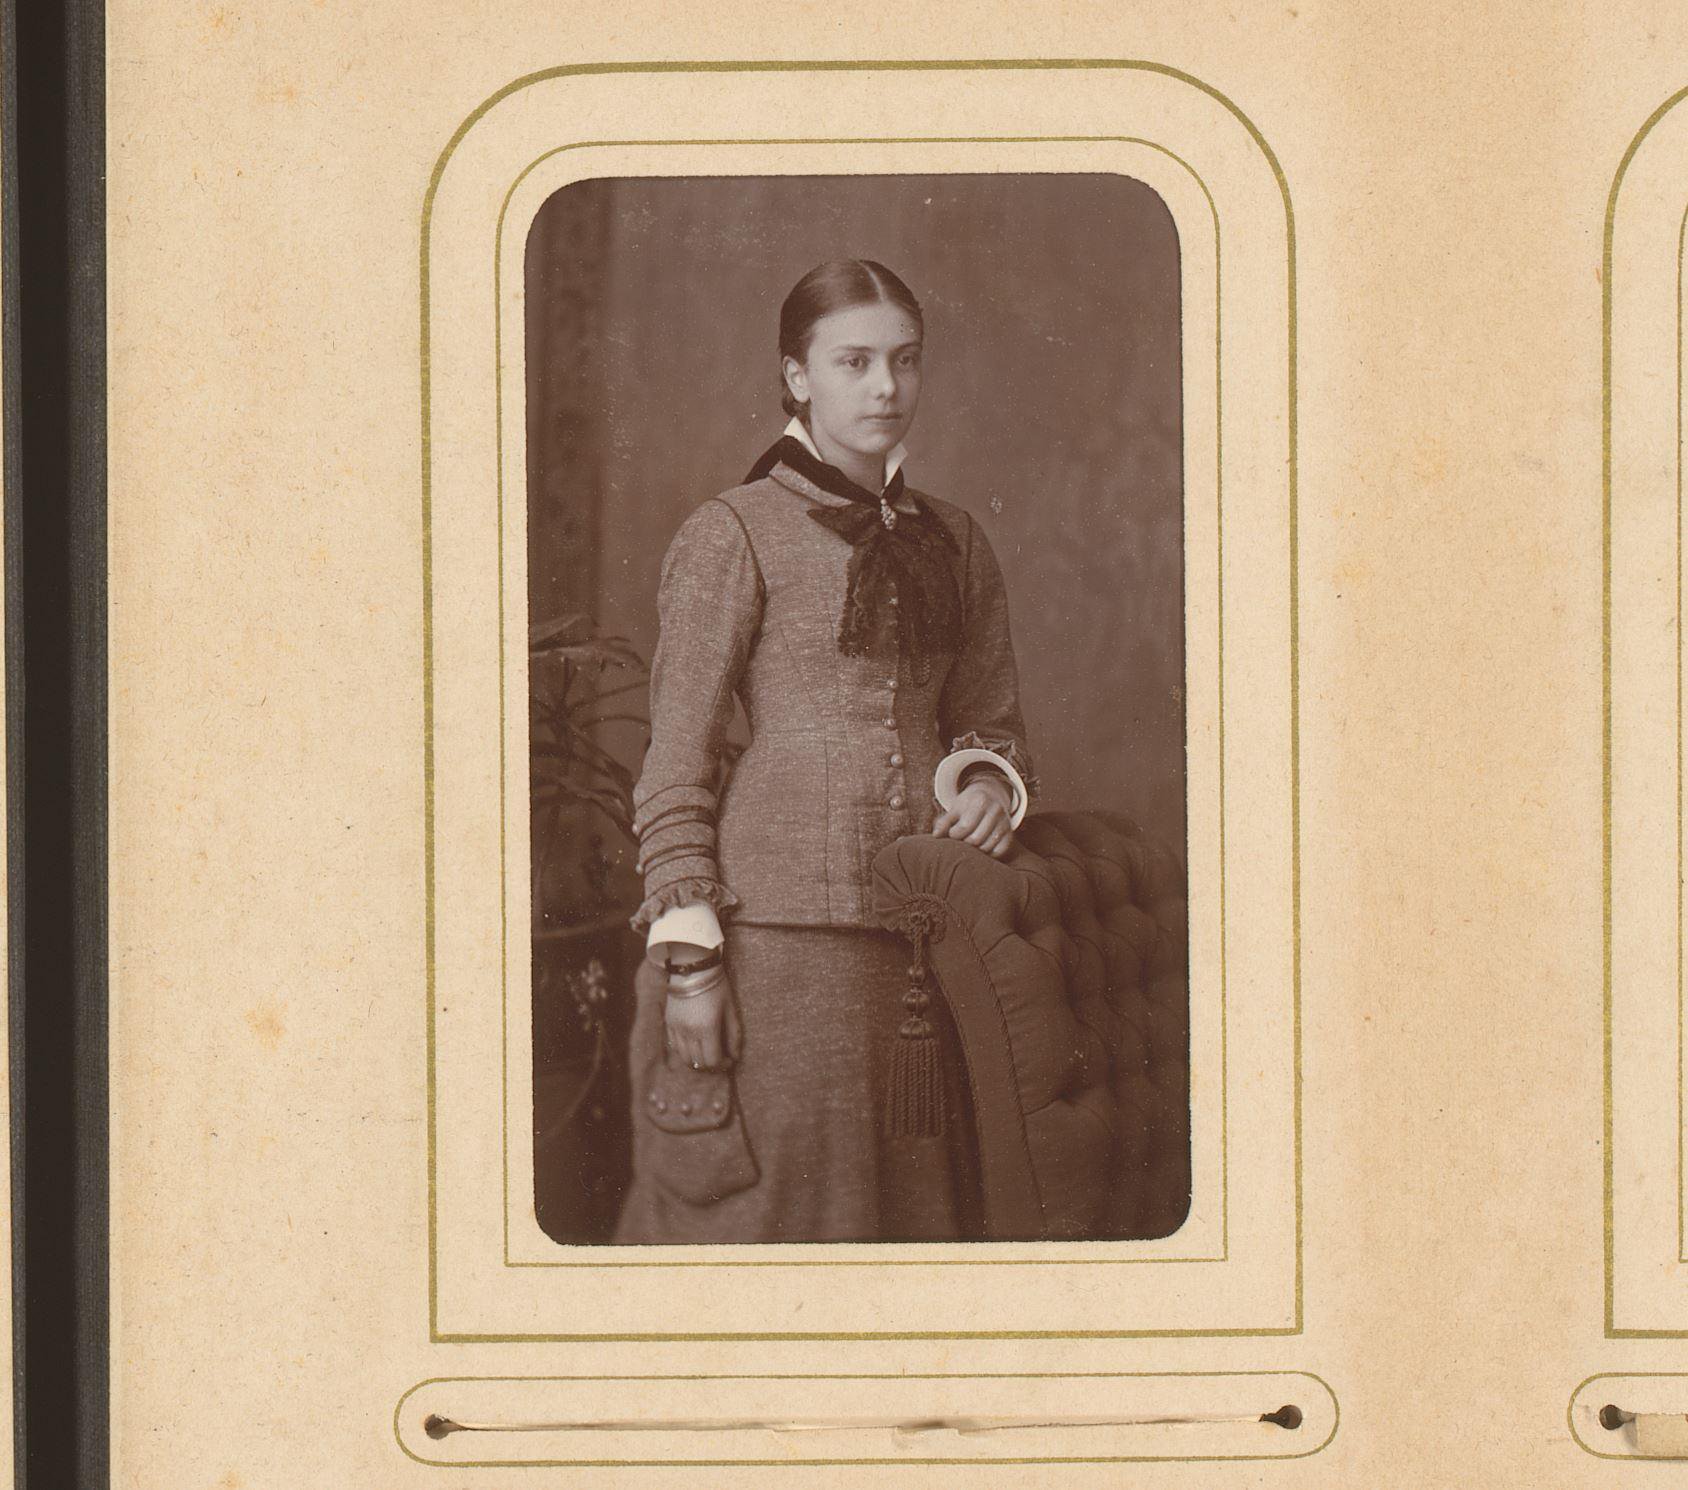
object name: carte de visite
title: Portret van een jonge vrouw, staand bij een stoel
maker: edmund risse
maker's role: fotograaf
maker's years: 1835-1891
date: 1880-1891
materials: cardboard, photographic support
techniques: collodion silver print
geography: norderney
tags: adolescent, young woman, maiden, historical persons - bb - woman, standing figure - aa - female human figure, chair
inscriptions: inscription: ‘EDMUND RISSE/ Hofphotograph/ Ihrer Kaiserl. u. Königl. Hoheiten/ Kronprinzen u.d. Frau Kronprinzessin/ Preussen & Deutschland/ NORDERNEY/ Strand Str. 72./ Bochum/ Friedrichstrasse 35./ Essen/ Limbeeker-Platz 8/ EMS/ am Bahnhof.’